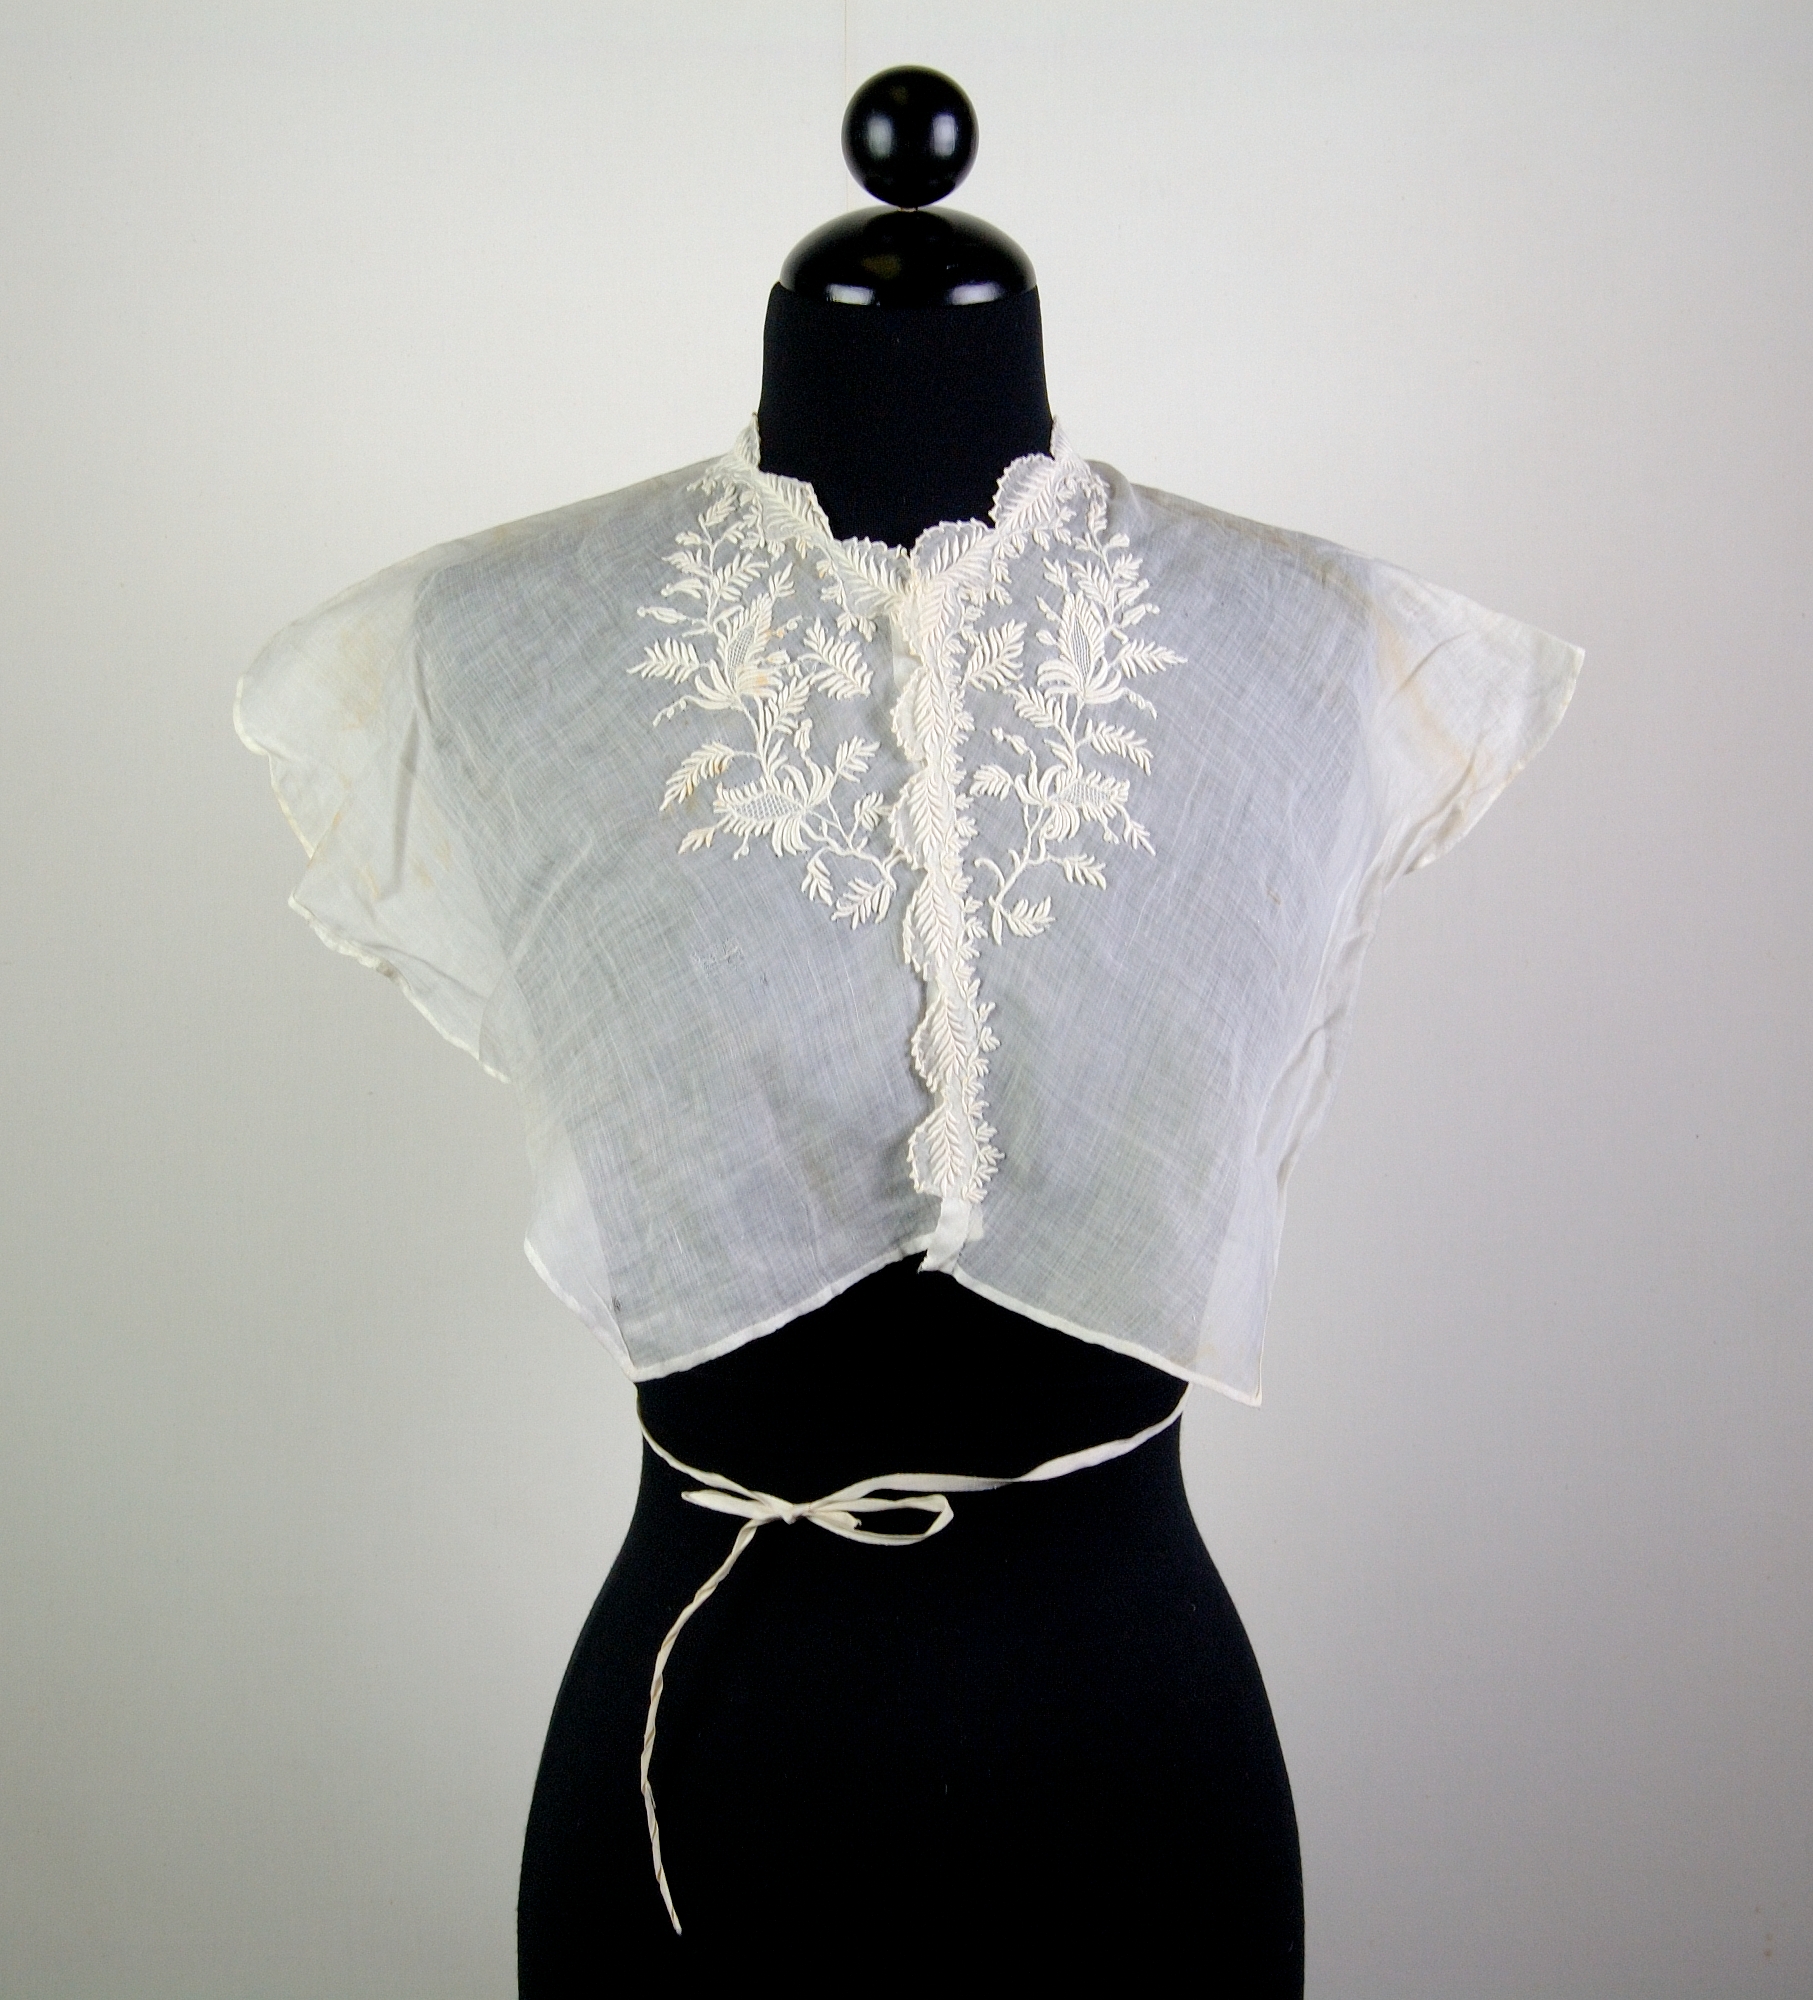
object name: chemise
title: Chemisette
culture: scottish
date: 1845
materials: cotton